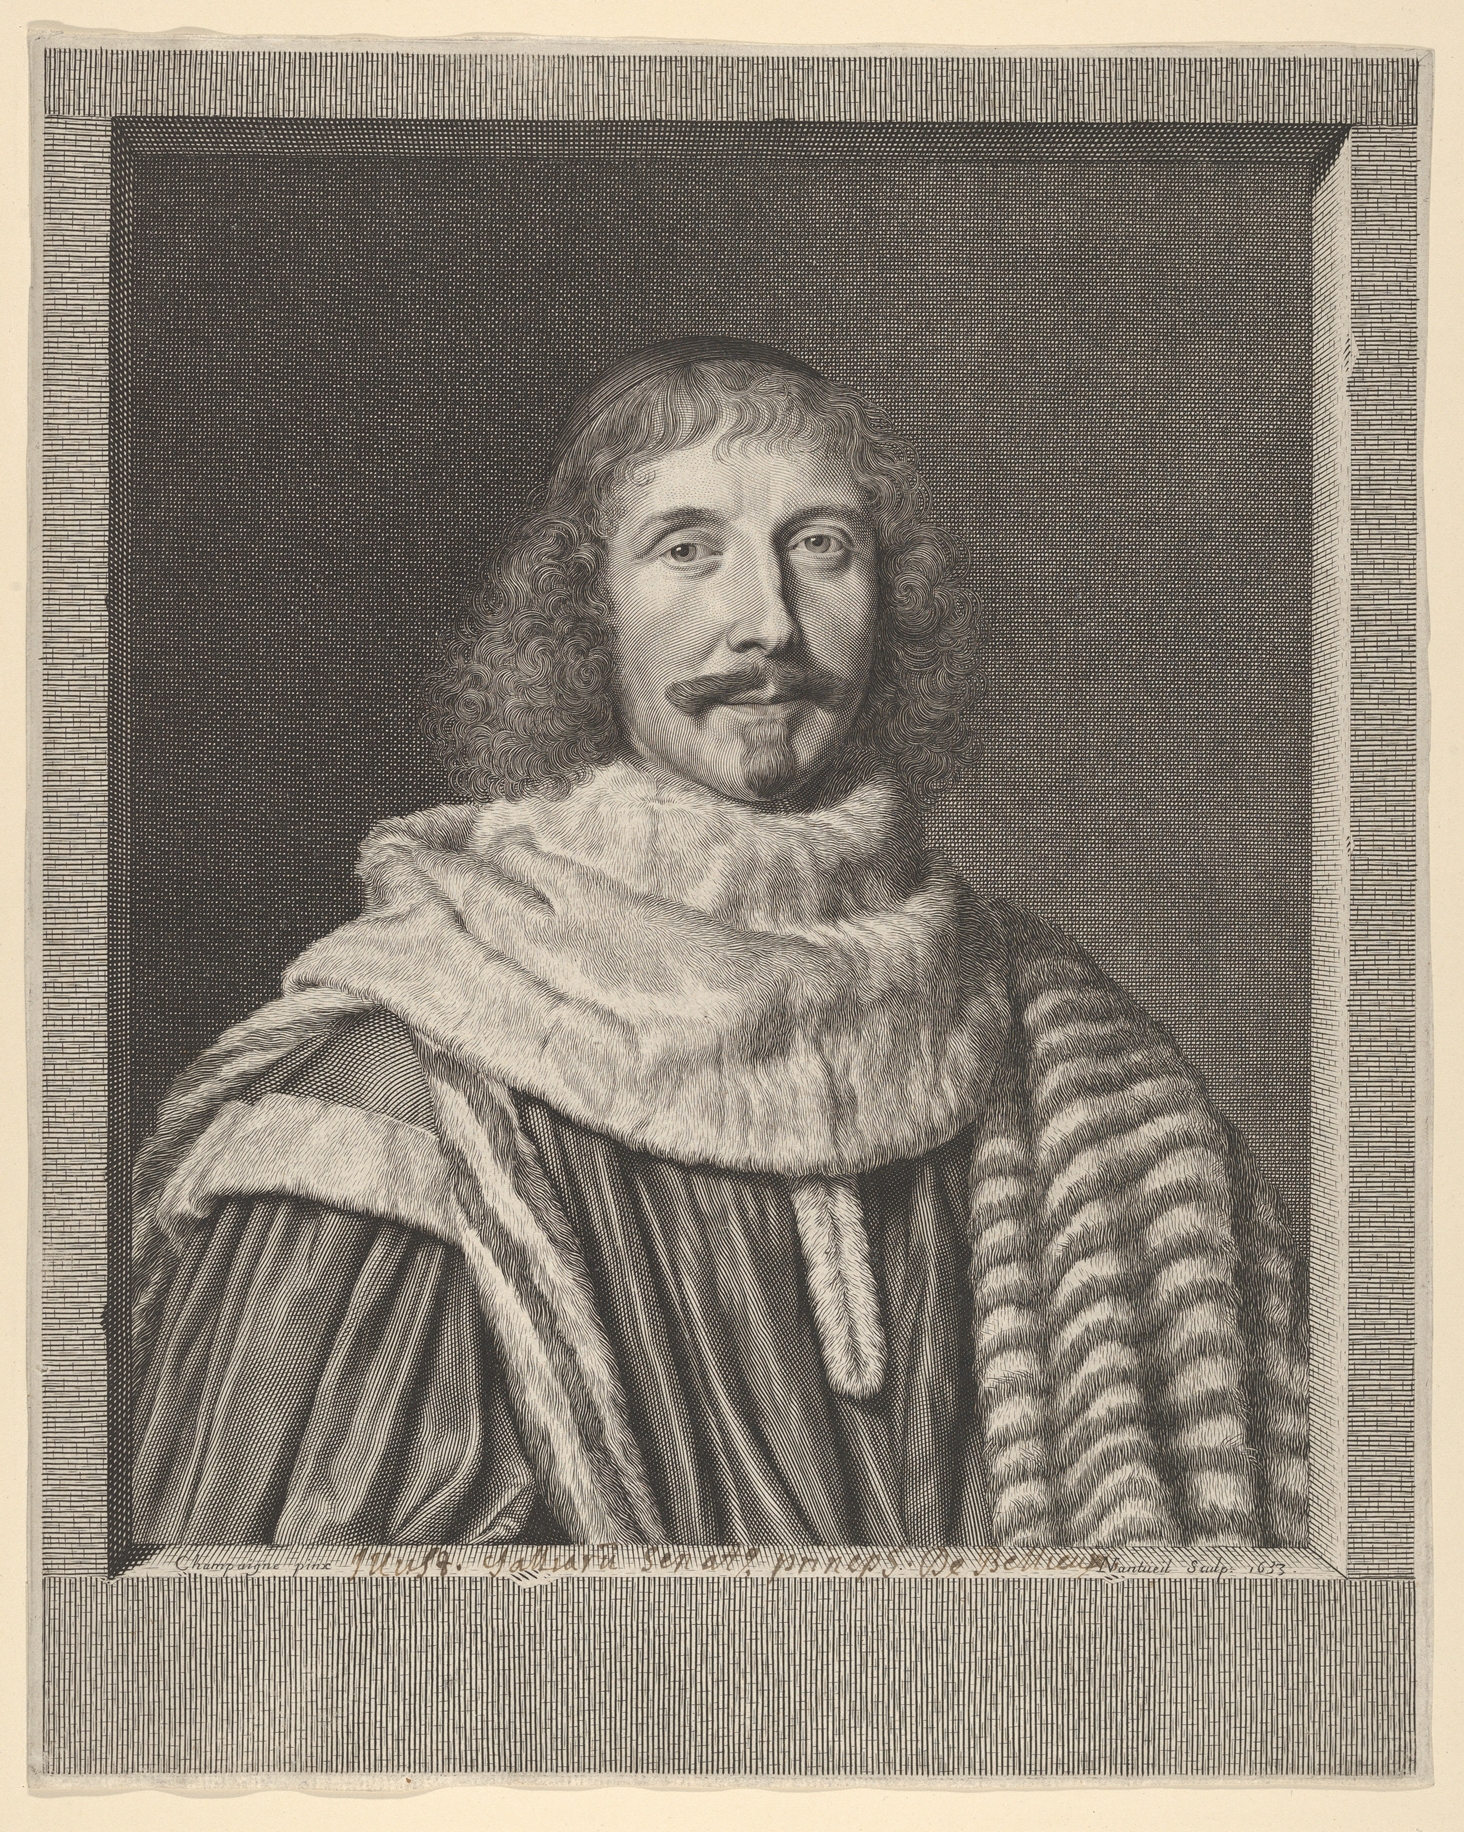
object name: print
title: Pompone II de Bellièvre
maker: robert nanteuil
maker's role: artist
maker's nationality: french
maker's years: 1623-1678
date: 1653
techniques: engraving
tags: men,portraits